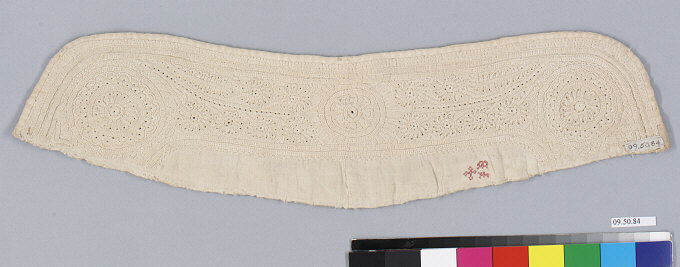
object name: cap fragment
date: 1701-1900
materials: linen